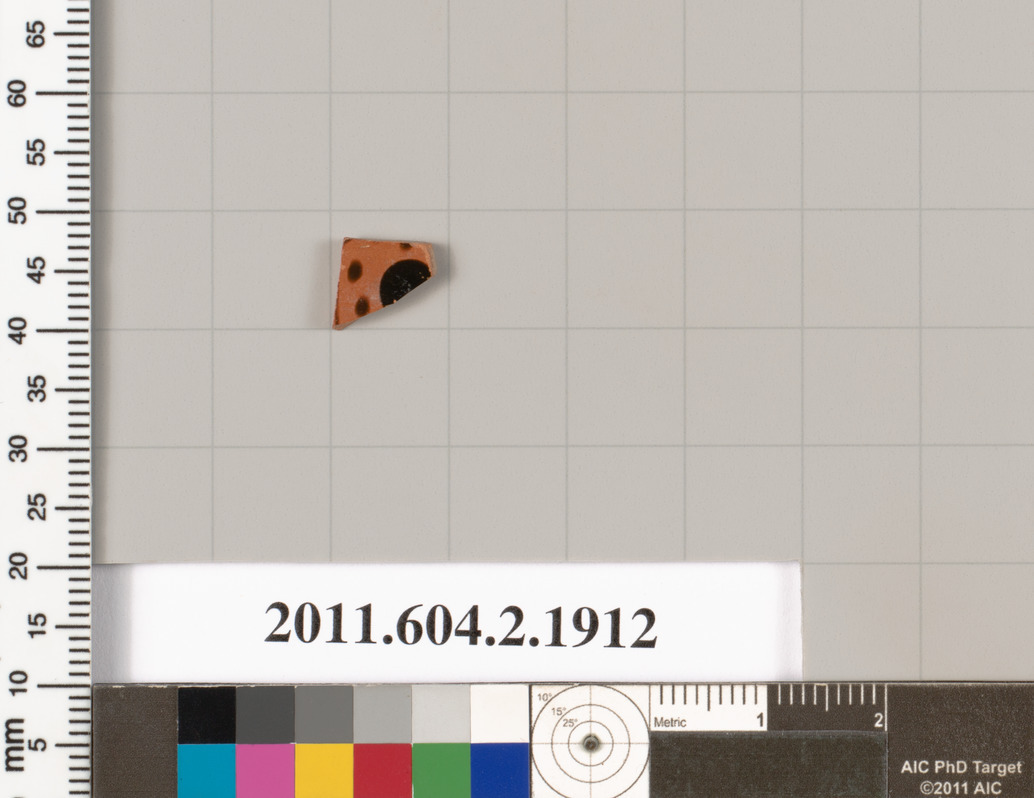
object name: skyphos fragment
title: Terracotta fragment of a skyphos (deep drinking cup)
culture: greek, attic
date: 460-430 BCE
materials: terracotta